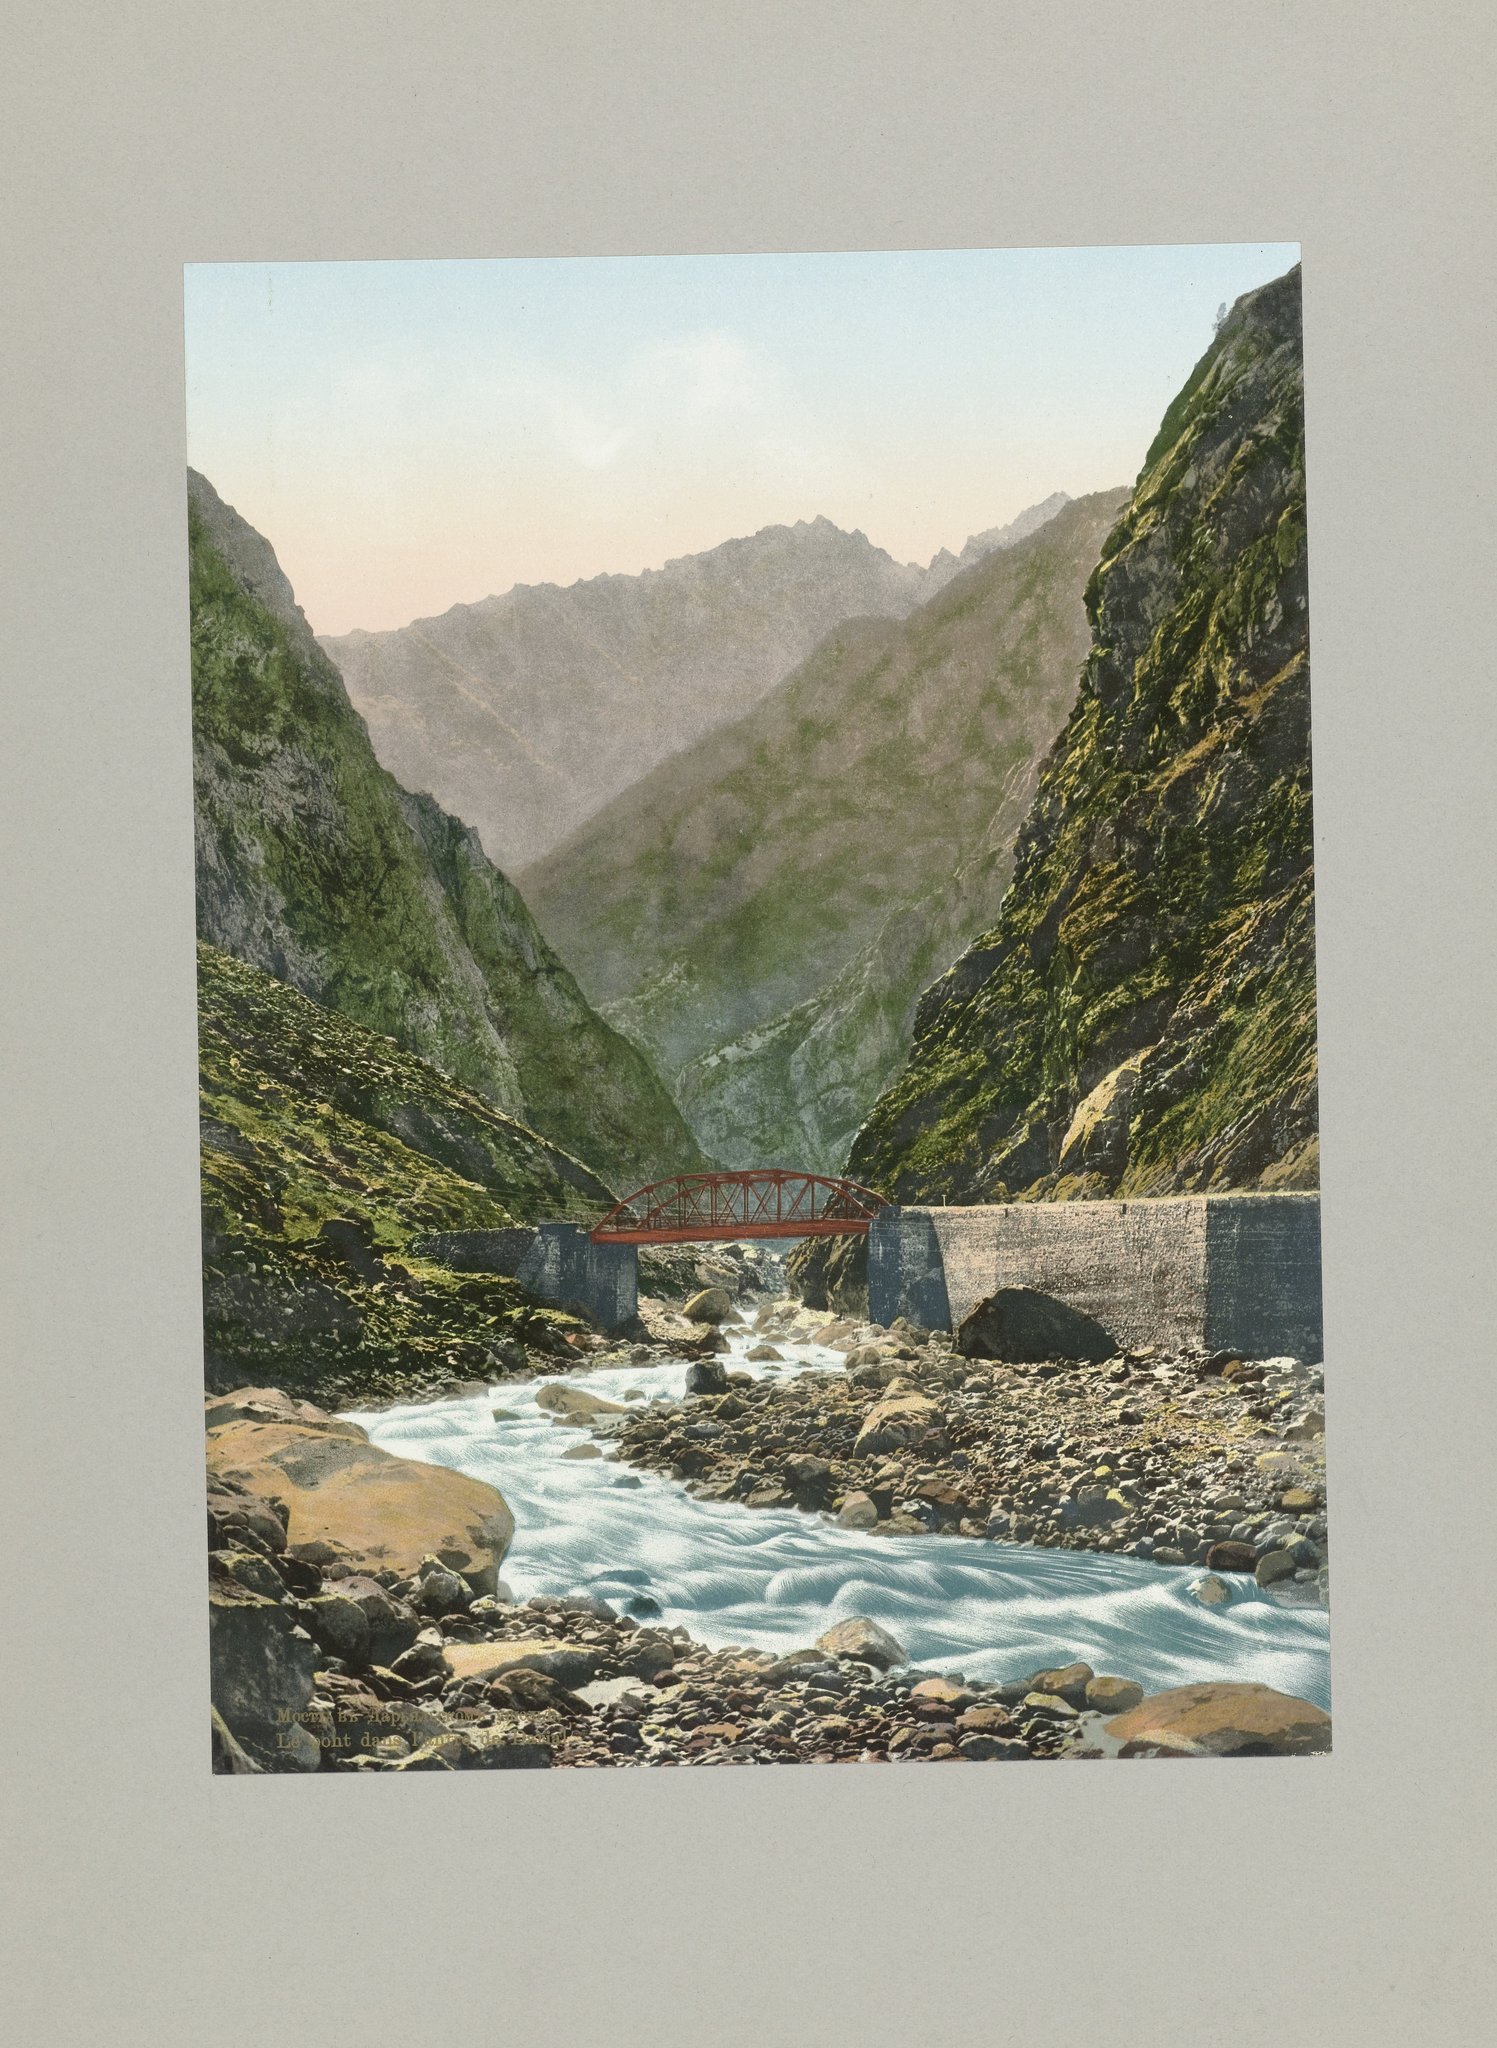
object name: photograph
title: Brug in de Darjalkloof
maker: Anonymous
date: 1895-1915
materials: cardboard, paper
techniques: photolithography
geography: georgia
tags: georgië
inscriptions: annotation: ‘38 idem’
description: Brug over rivier in de Darjalkloof. Linksonder staat de titel in het Russisch en in het Frans.